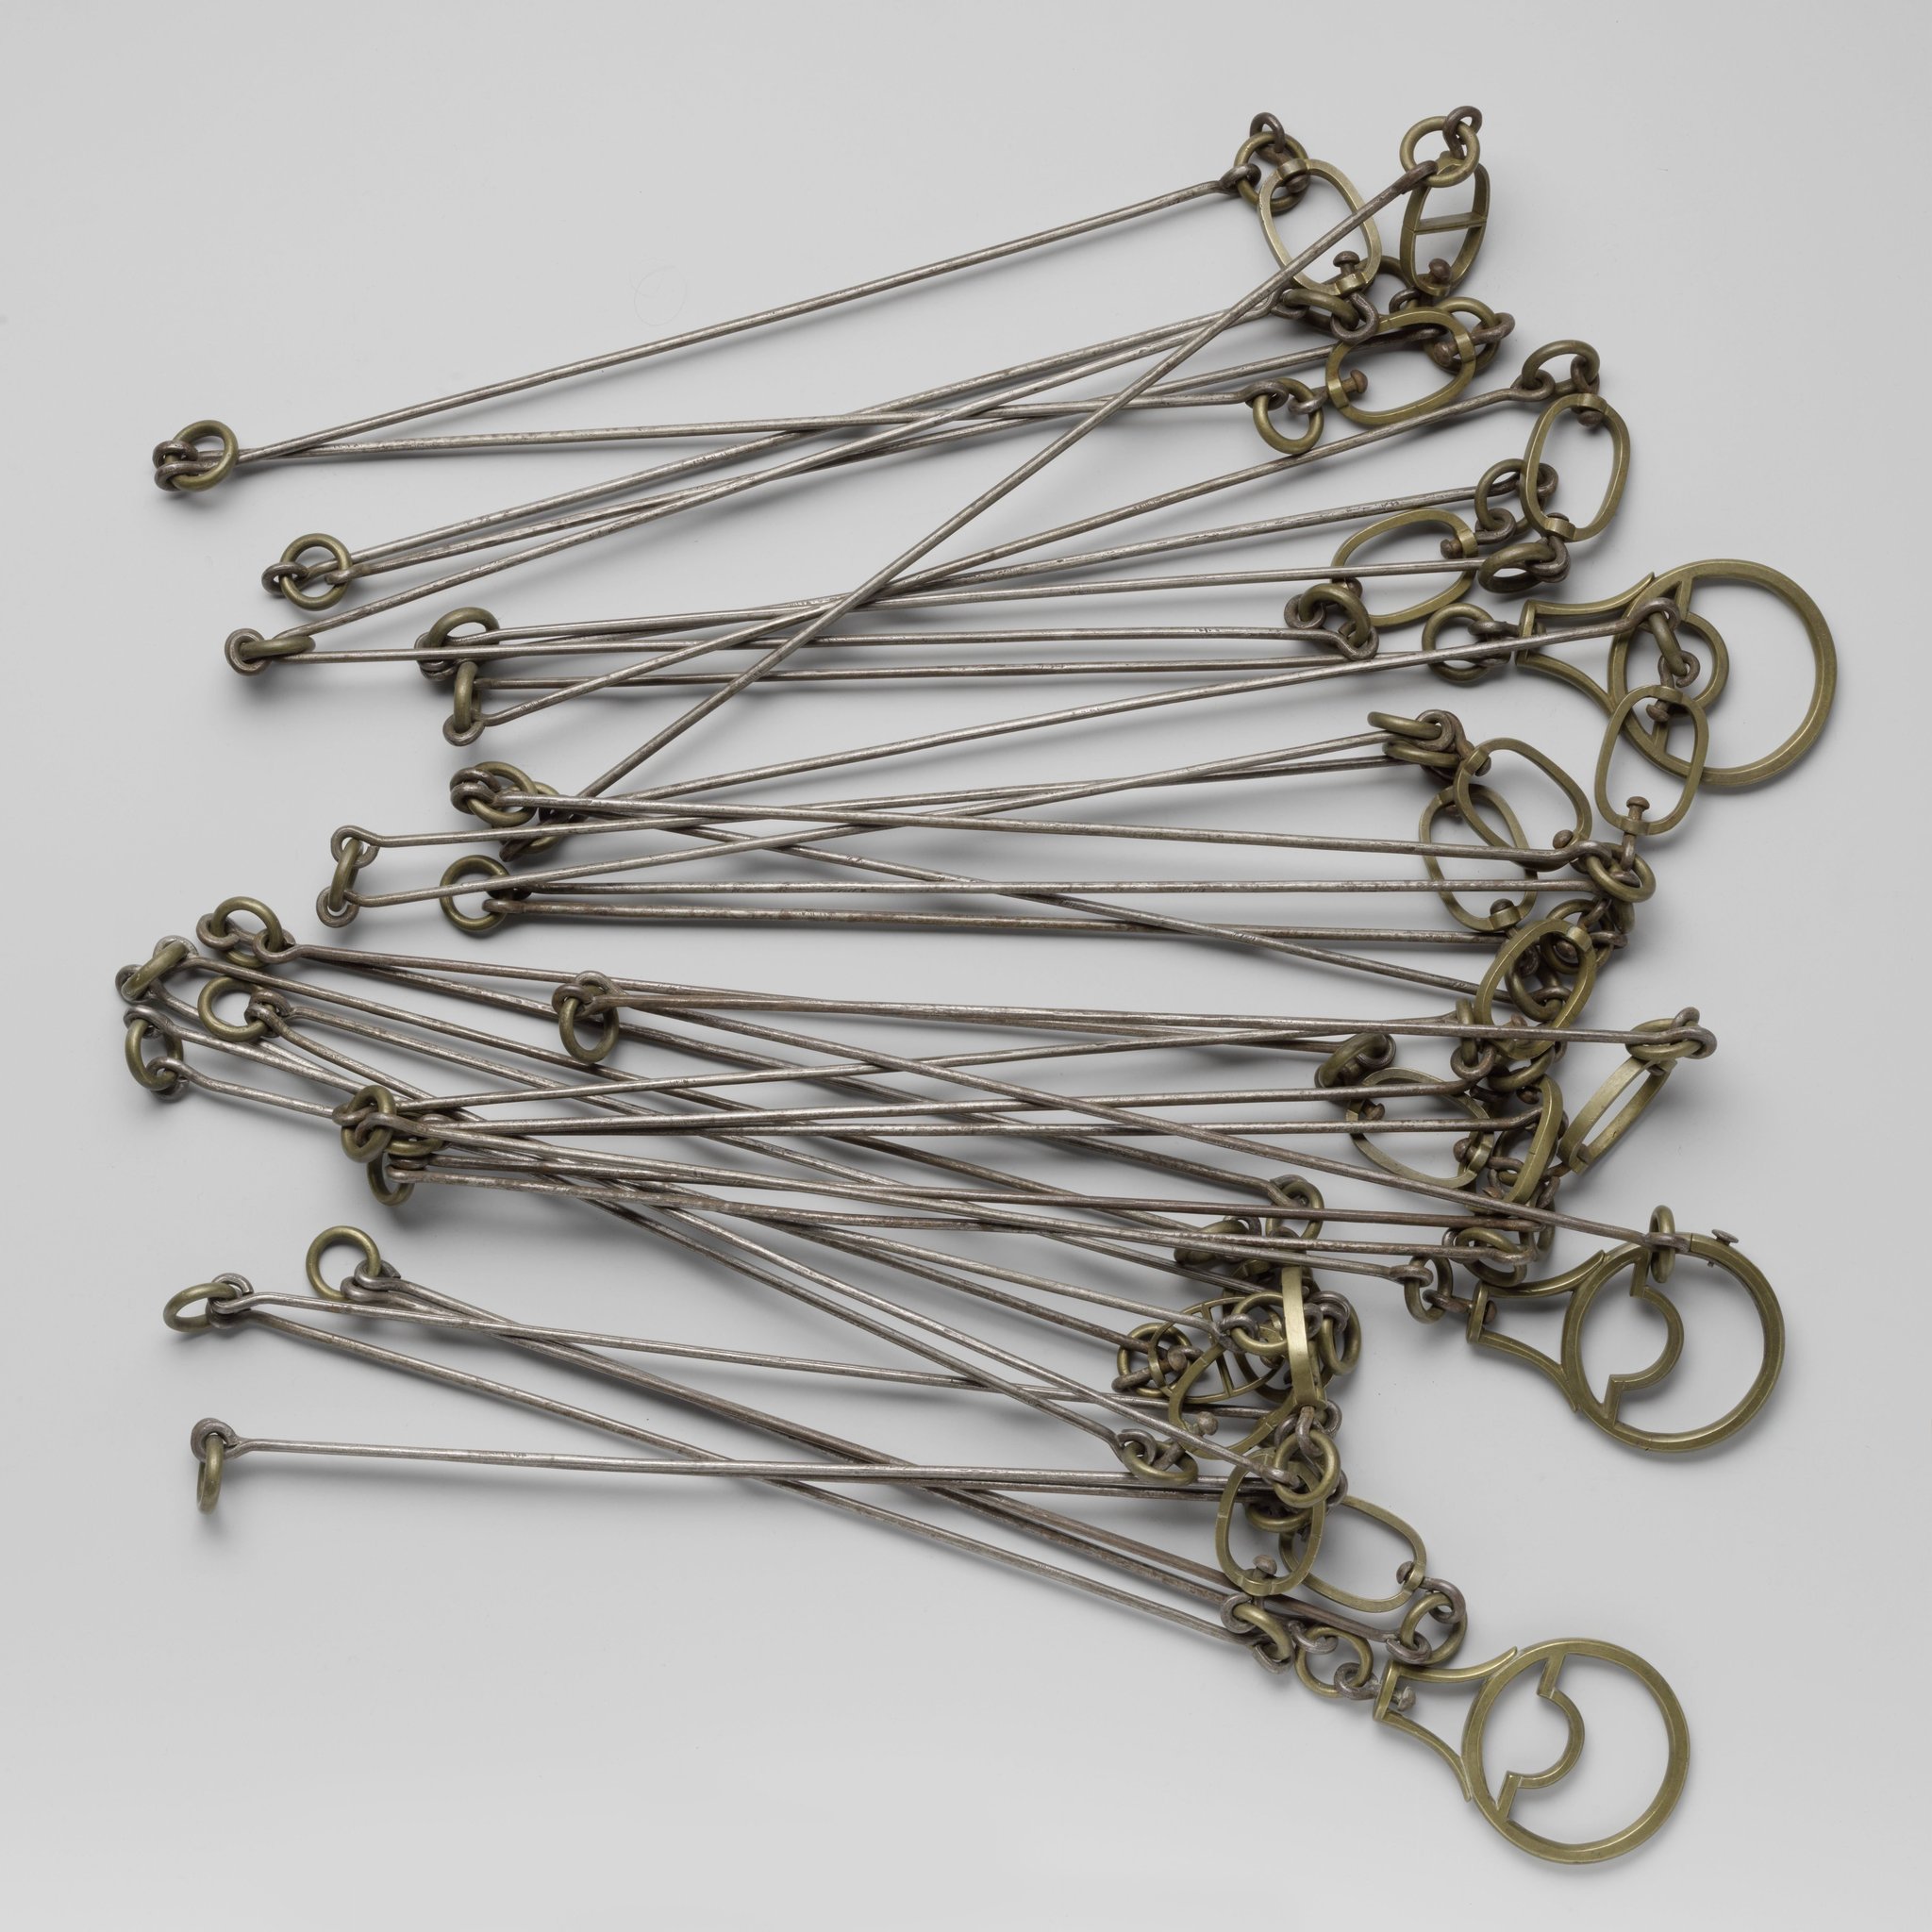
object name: measuring chain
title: Landmetersketting van 20 meter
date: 1800-1850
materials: brass, iron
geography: amsterdam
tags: netherlands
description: Meetketting met verende ring in twee delen van 10 meter te delen. Per schakel 50 centimeter (van ring tot ring). Per twee schakels voorzien van ovale ring met keep. Aan het begin een rond messing handvat.